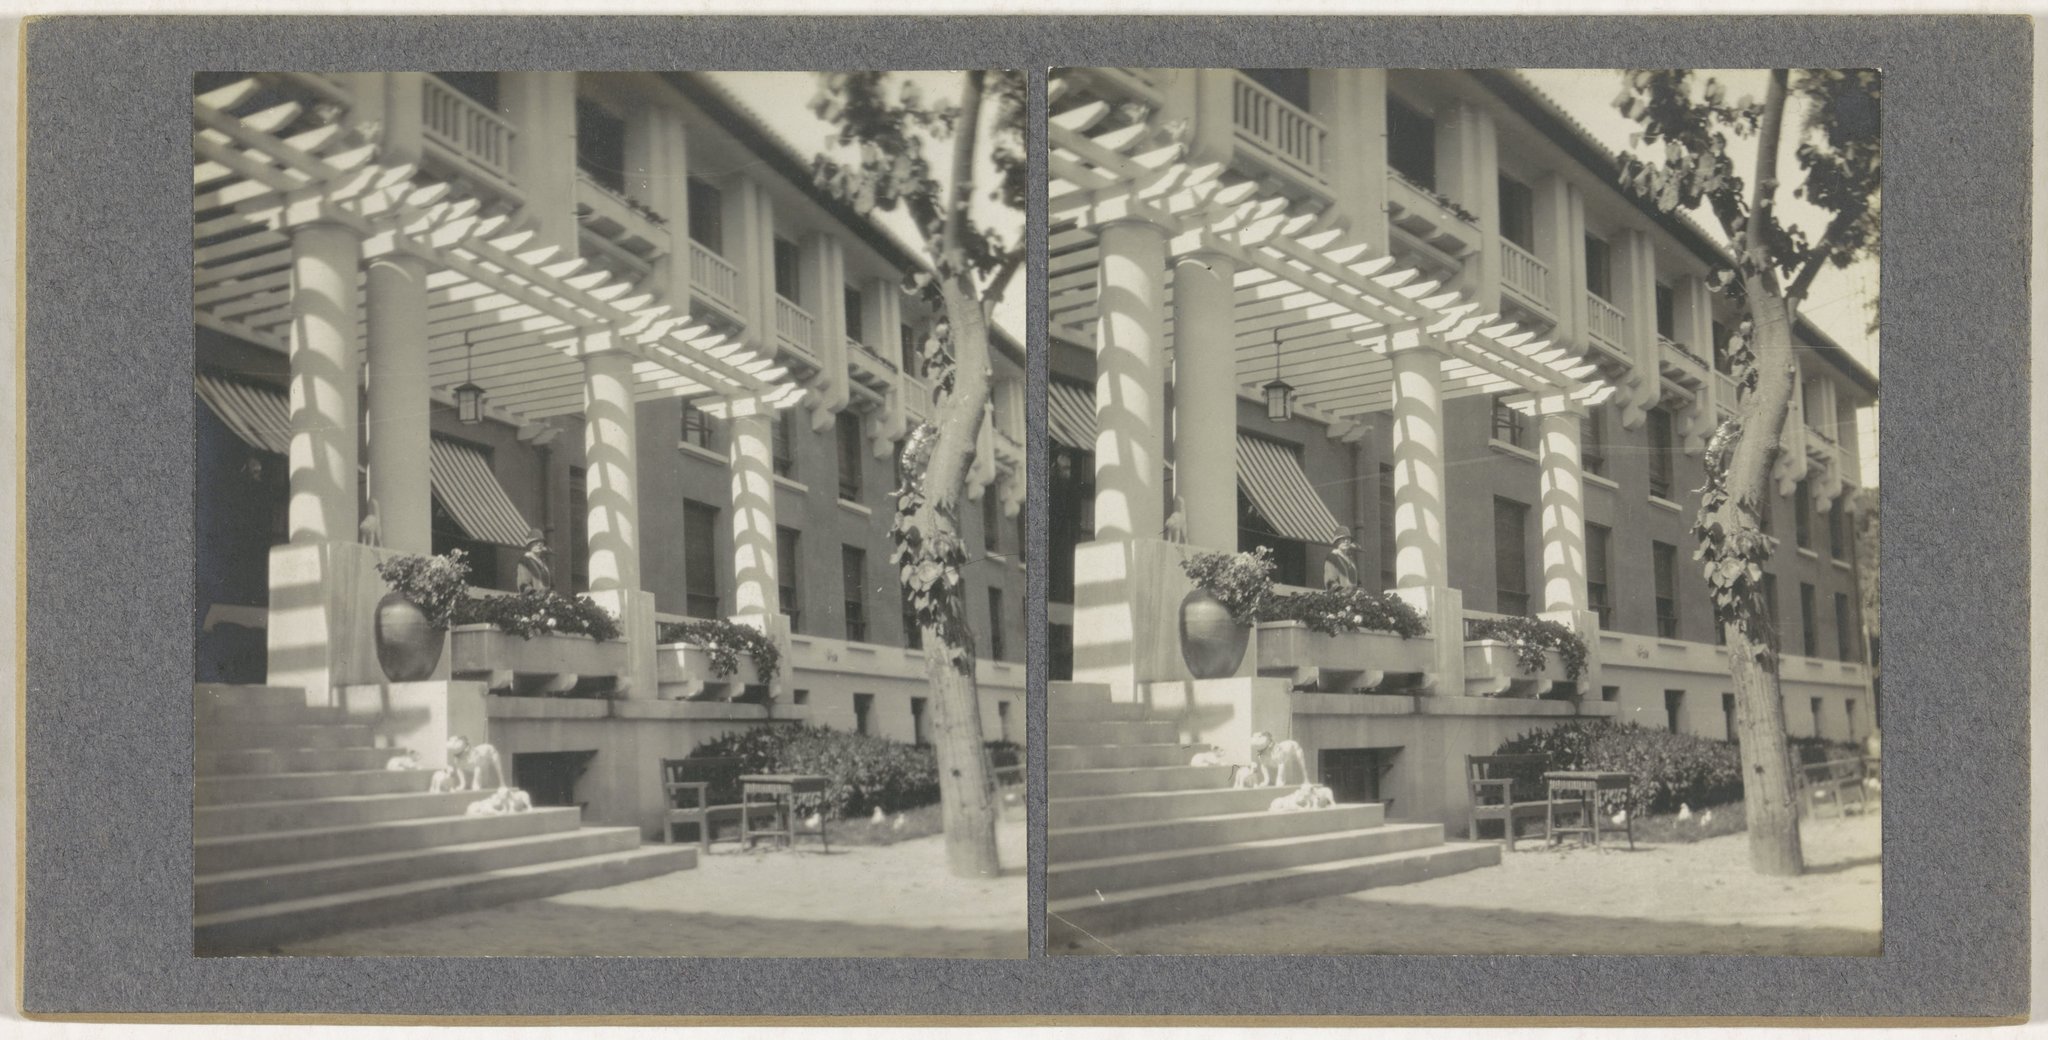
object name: stereograph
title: Huis te Millau, Frankrijk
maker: Anonymous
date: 1928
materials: cardboard, paper, photographic support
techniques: gelatin silver print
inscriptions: inscription: ‘Millau / Septembre 1928’